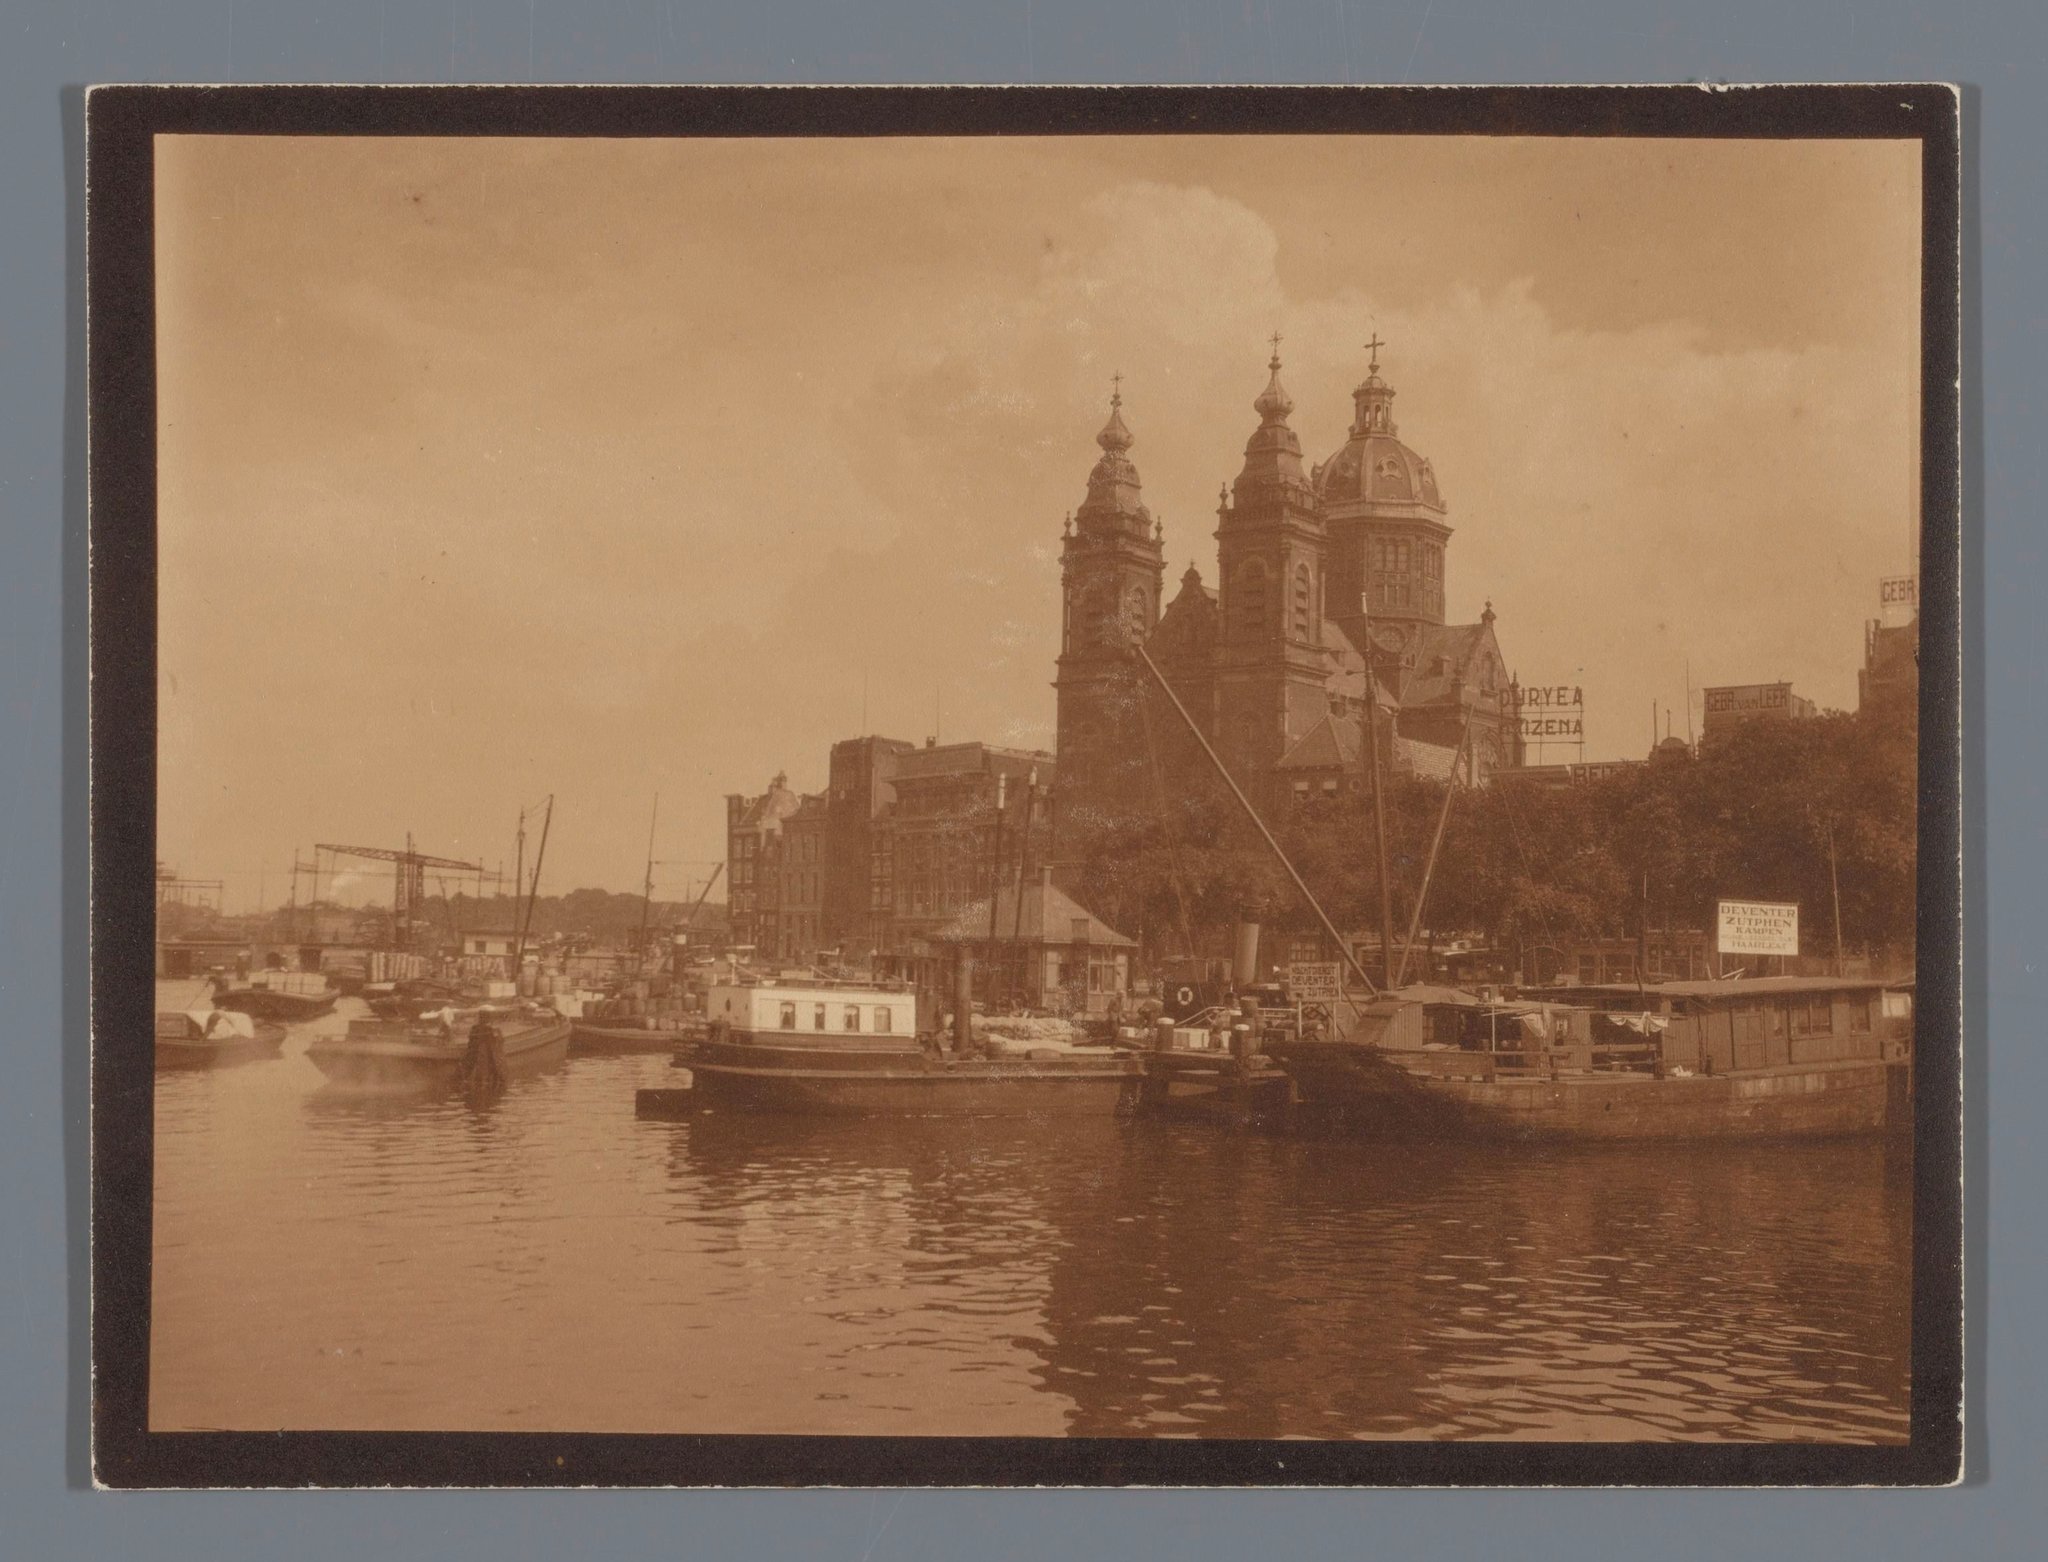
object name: photograph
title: Gezicht op de Sint-Nicolaaskerk te Amsterdam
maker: léonard missone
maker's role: fotograaf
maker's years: 1870-1943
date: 1913-1940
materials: photographic support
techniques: gelatin silver print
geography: amsterdam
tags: church (exterior), canals, waters (in city)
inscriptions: inscription: ‘amsterdam’